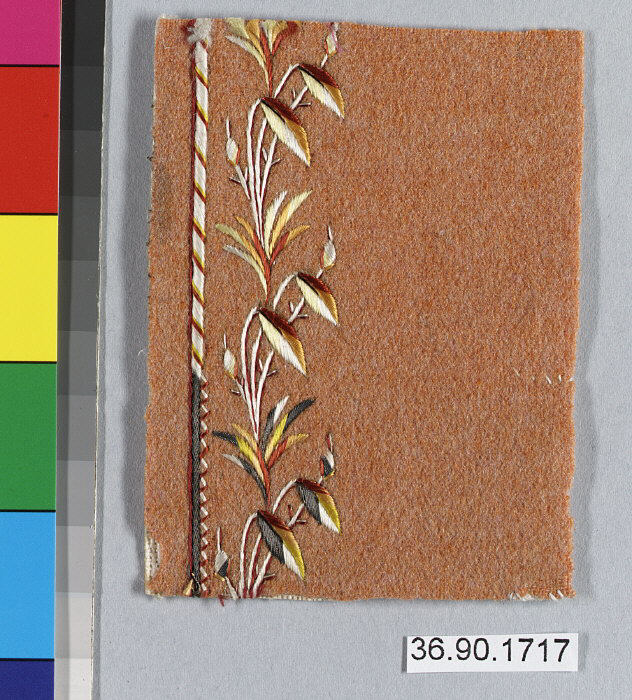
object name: sample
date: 1801-1833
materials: felt, metal thread, silk